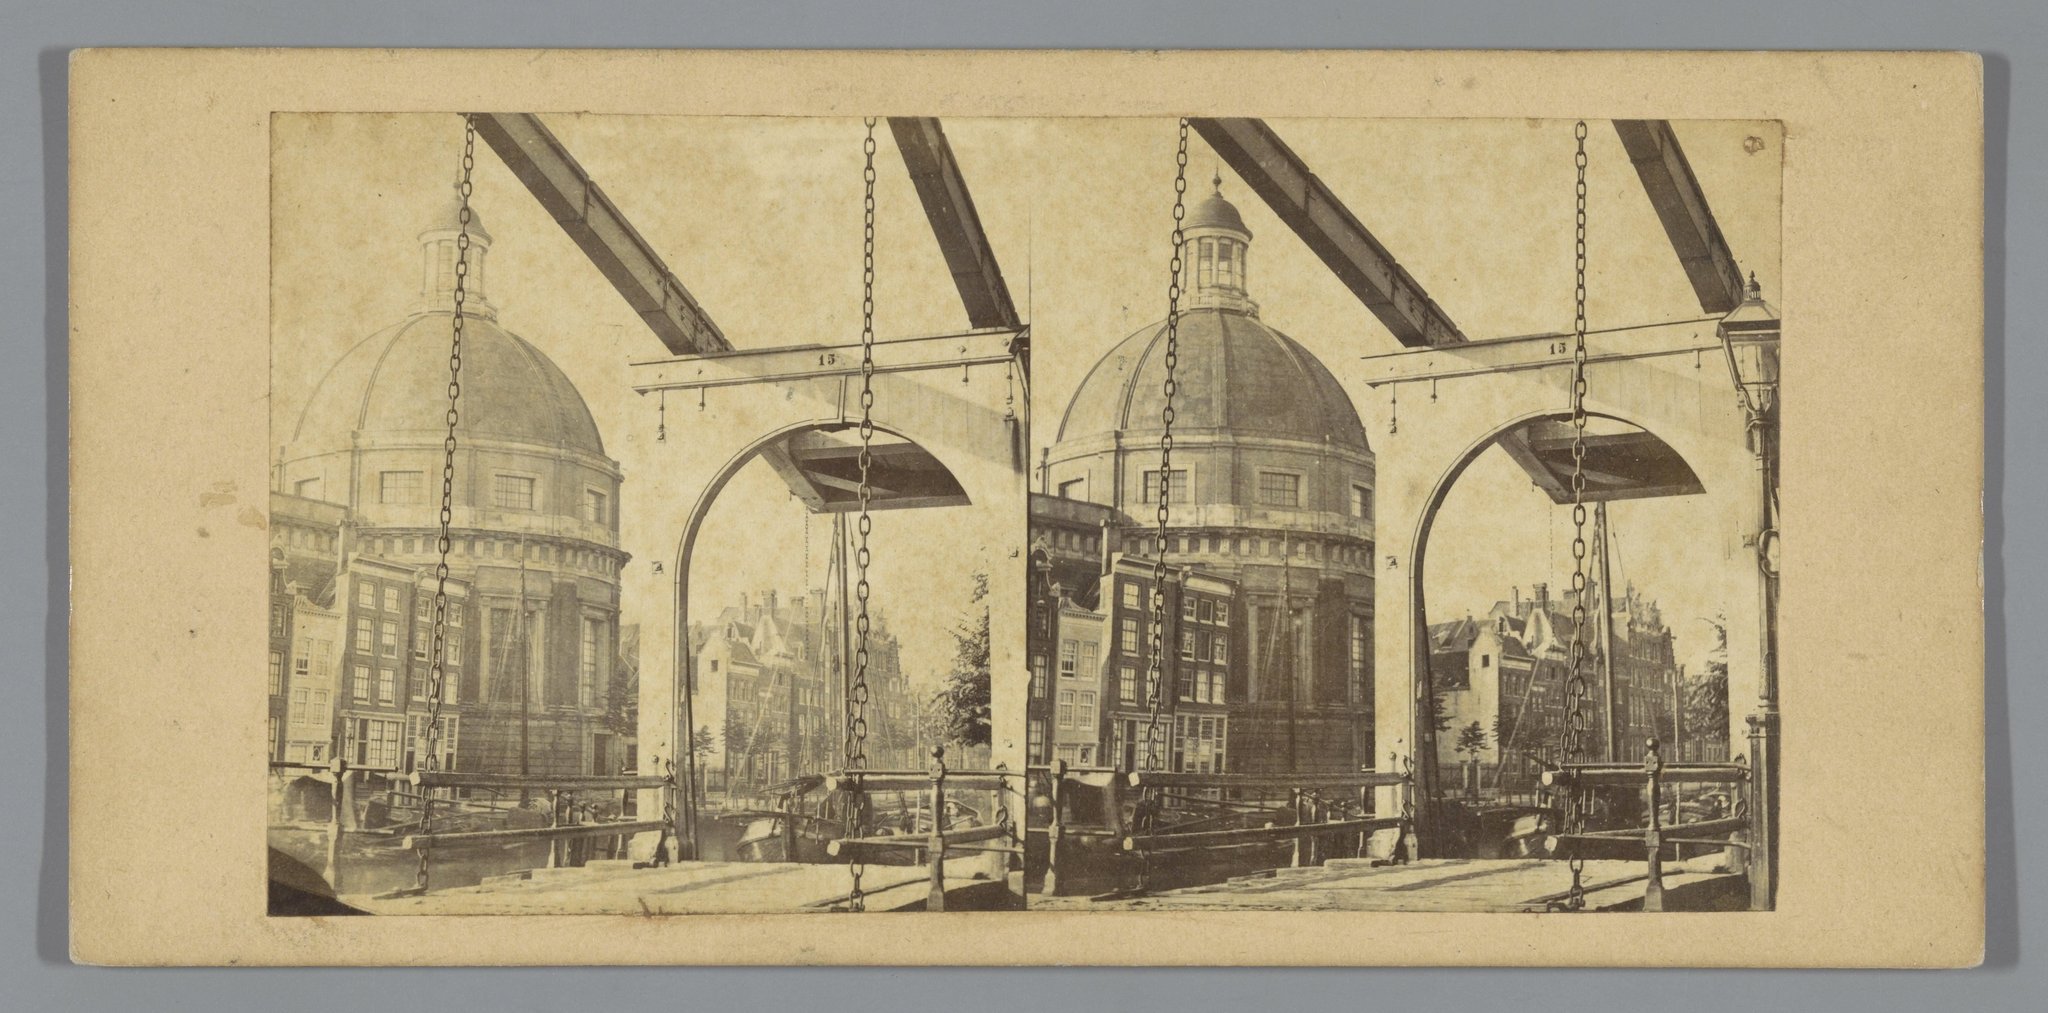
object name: stereograph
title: Amsterdam. Ronde Lutherse Kerk. Singel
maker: Anonymous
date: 1857-1870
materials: cardboard, paper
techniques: albumen print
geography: amsterdam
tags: church (exterior), bridge in city across river, canal, etc.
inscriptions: inscription: ‘M [?]’, inscription: ‘Singel, RLuthkerk/ Amsterdam’, inscription: ‘CF’